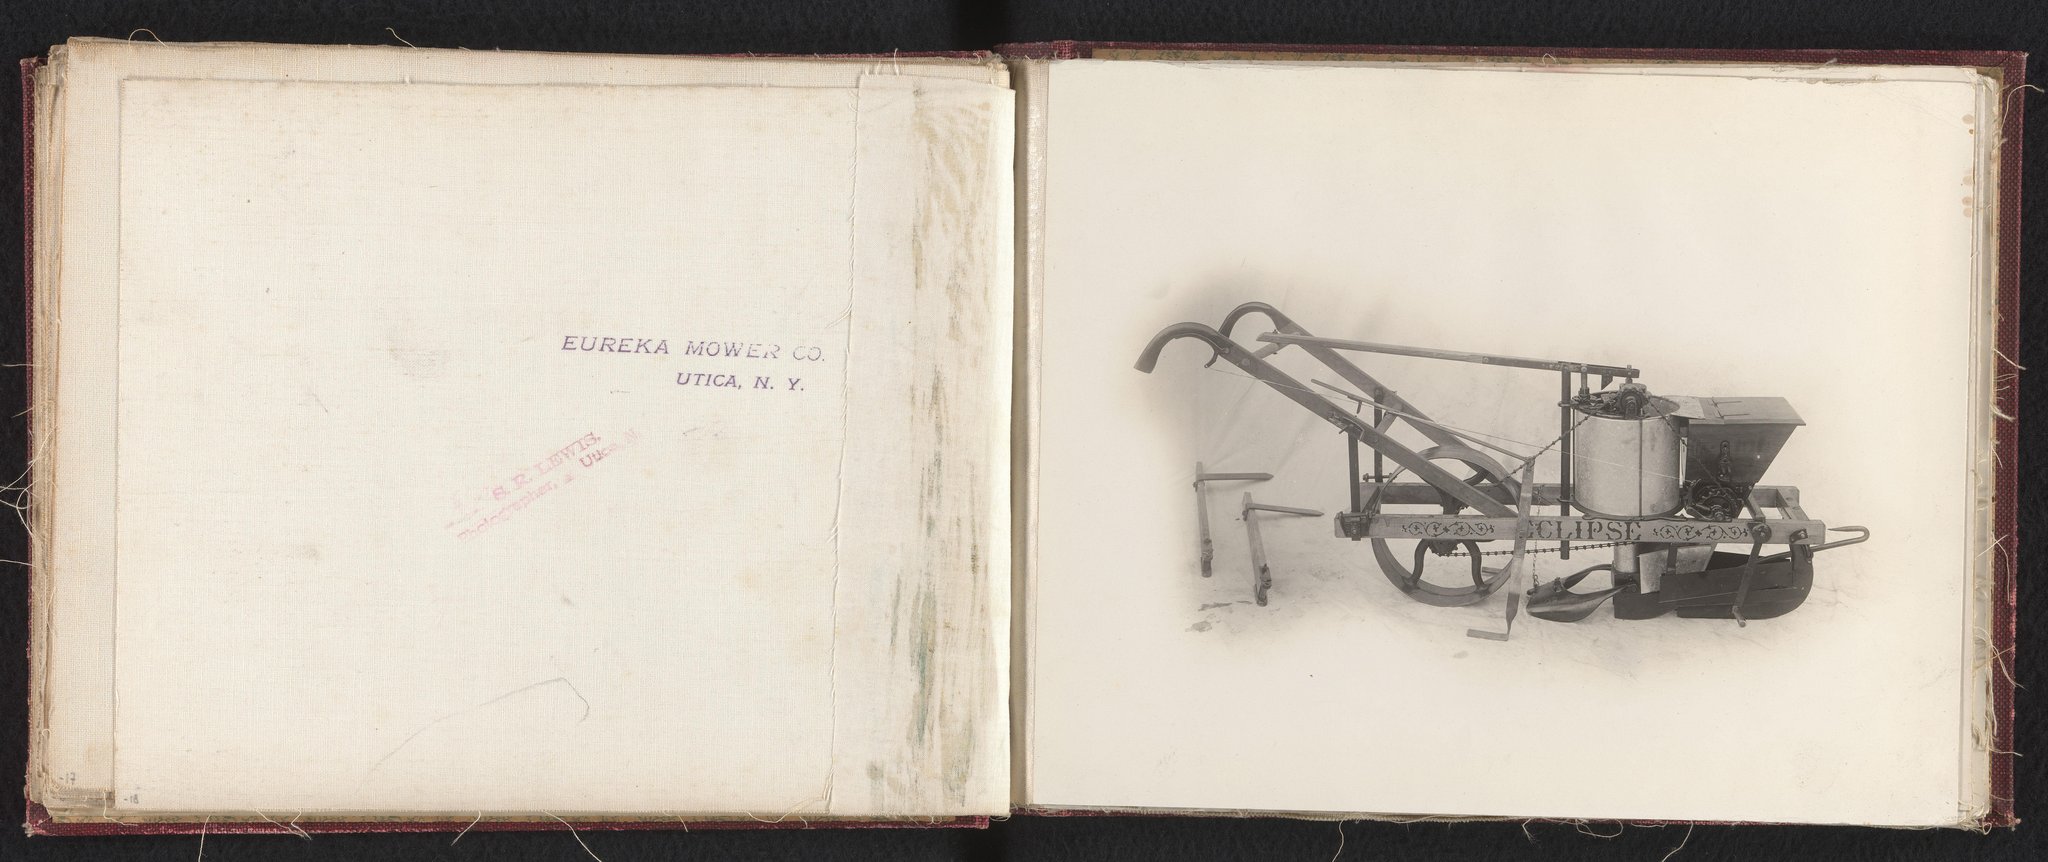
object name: photograph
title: Landbouwwerktuig van de Eureka Mower Co. te Utrica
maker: lewis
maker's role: fotograaf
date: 1915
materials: paper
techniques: gelatin silver print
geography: utica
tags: agricultural implements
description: Foto op zestiende ongenummerde pagina na voorplat.